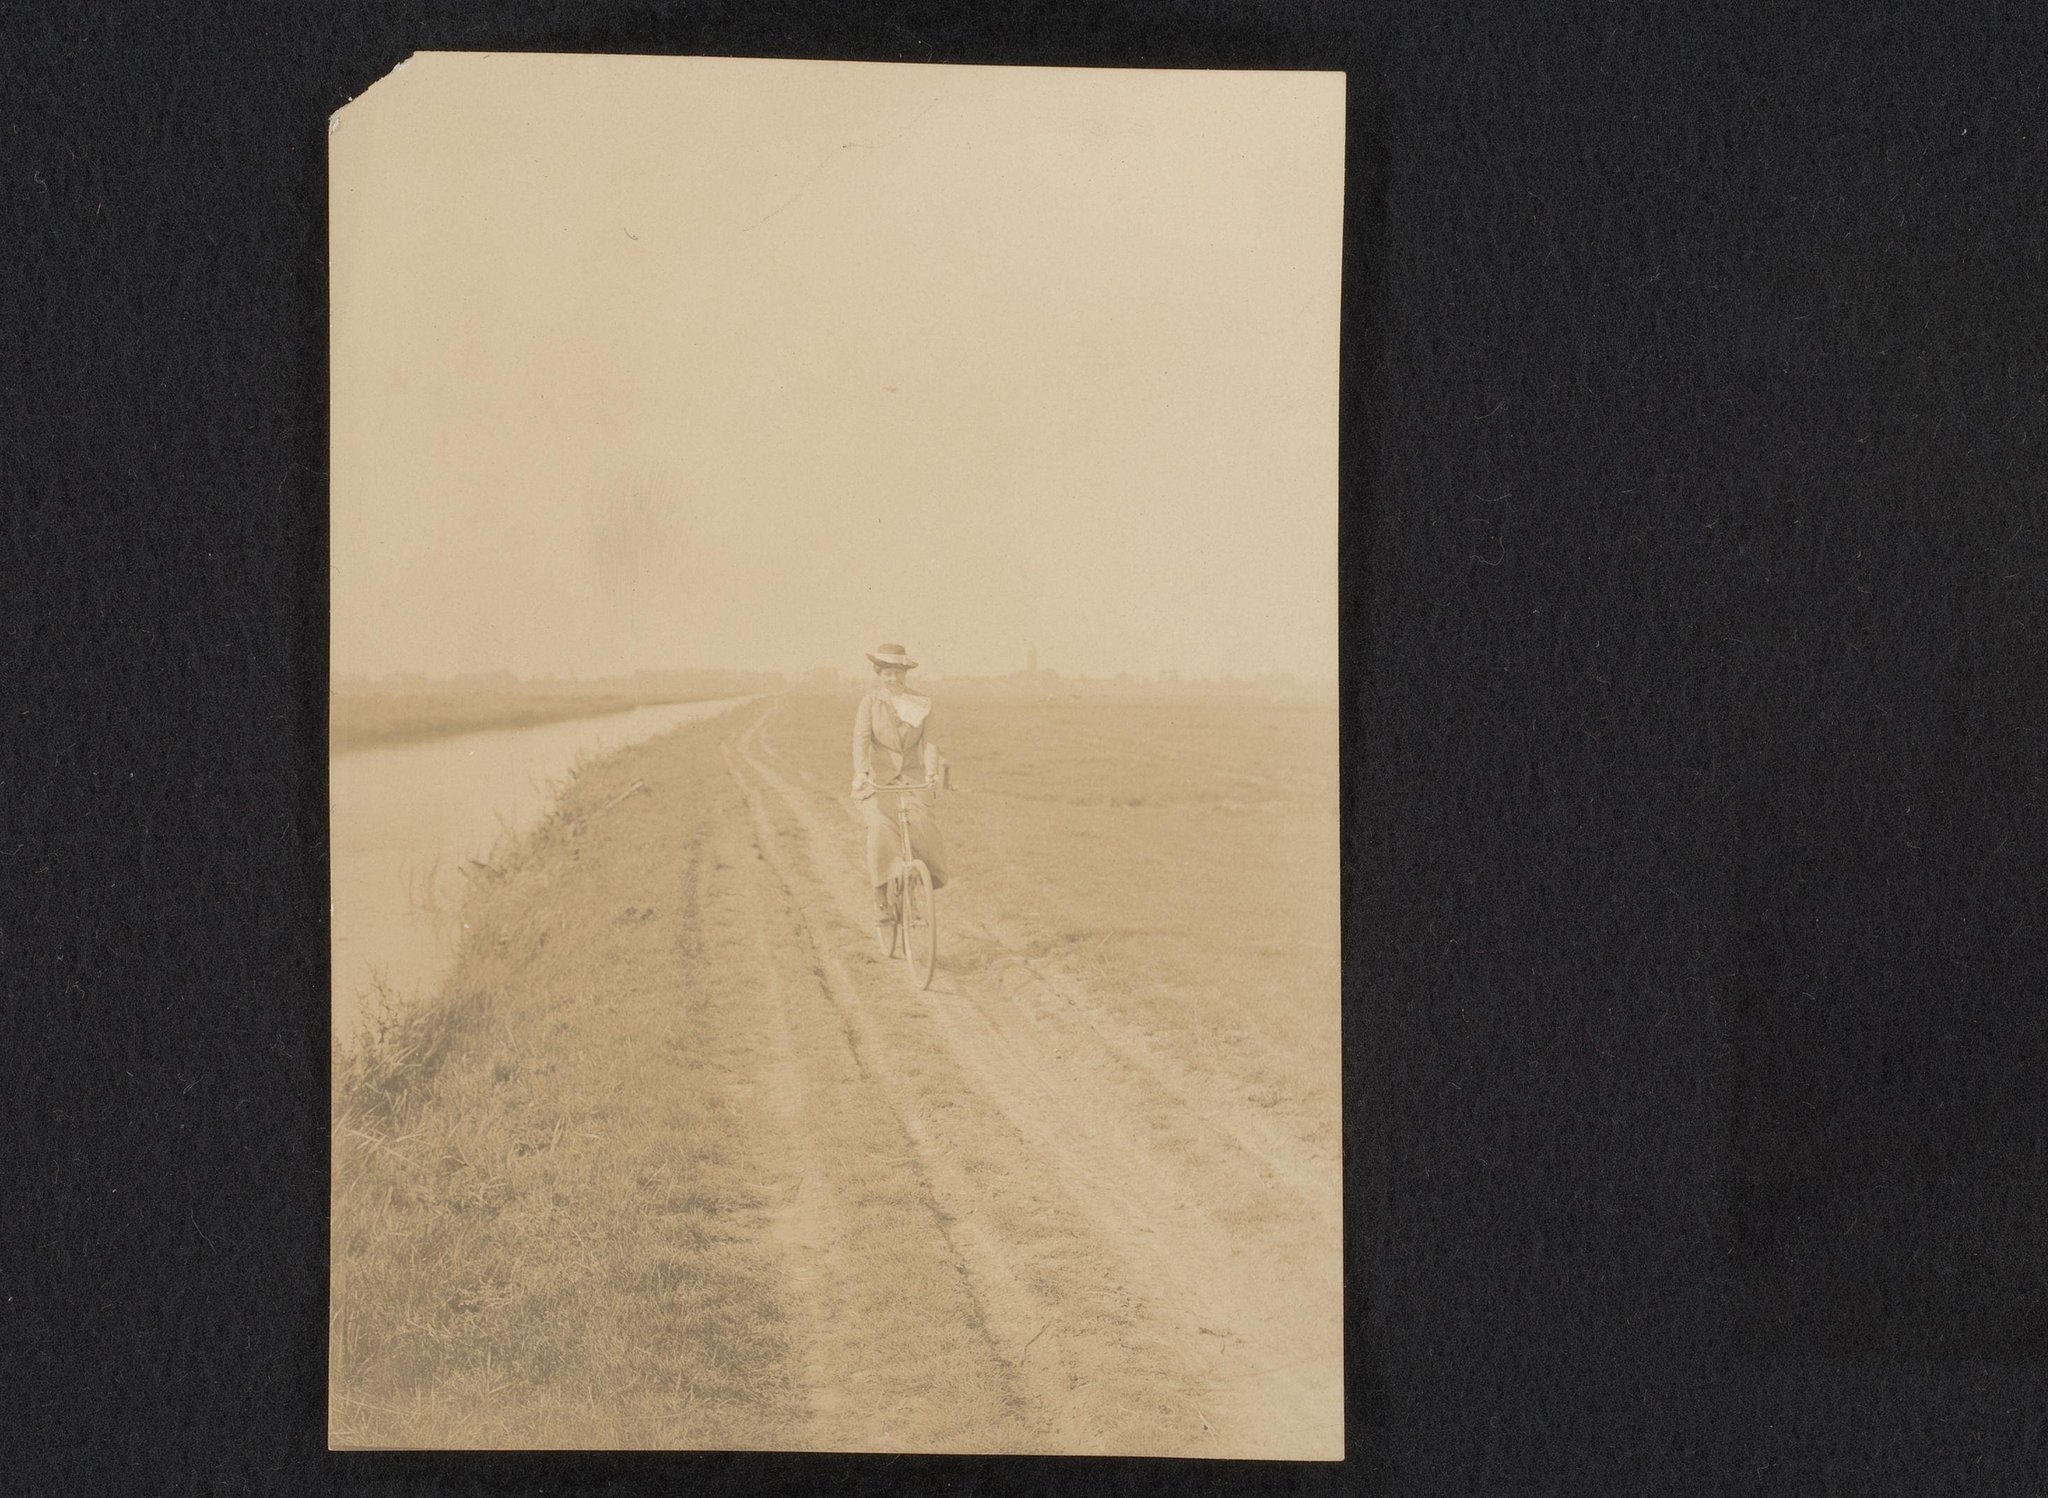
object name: photograph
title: Caroline van den Berg op de fiets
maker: hendrik herman van den berg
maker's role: amateurfotograaf, jurist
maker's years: 1875-1944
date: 1913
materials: paper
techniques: gelatin silver print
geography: blaricum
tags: the hague, caroline louise van den berg-van den berg, historical persons - bb - woman, bicycle